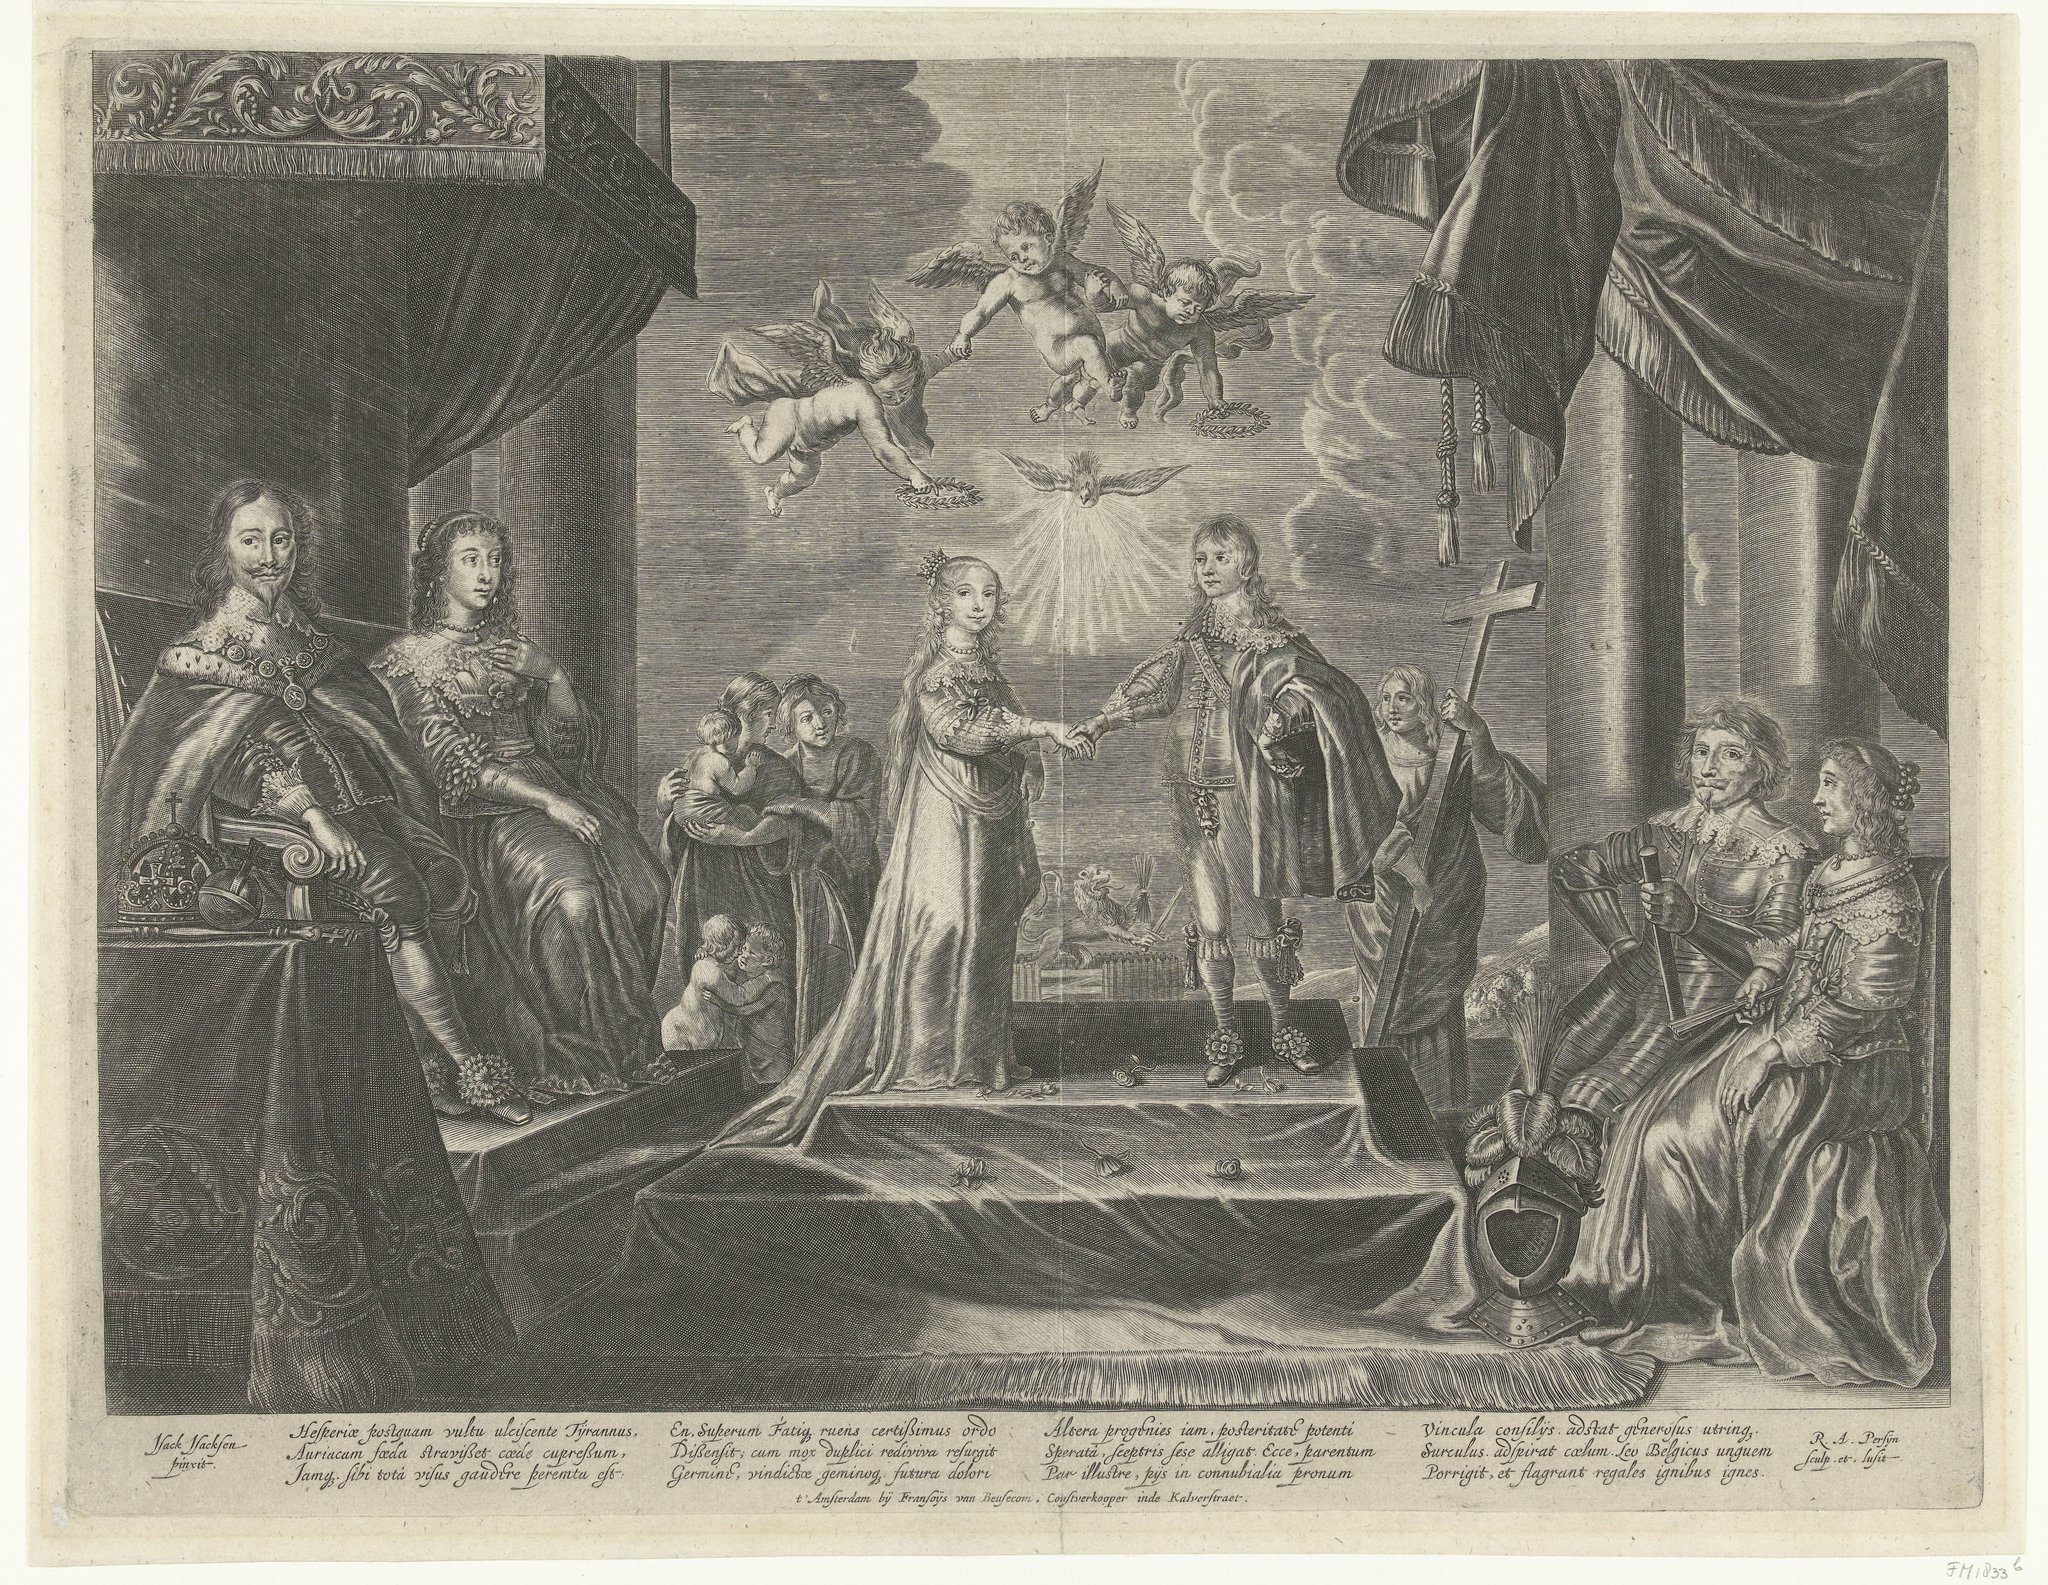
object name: print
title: Huwelijk van prins Willem II en Maria Stuart, 1641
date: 1641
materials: paper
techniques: engraving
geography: amsterdam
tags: henriëtta maria van frankrijk (koningin van engeland, schotland en ierland), delft, the hague, frederick henry (prince of orange), william ii (prince of orange), amalia of solms-braunfels, mary henrietta stuart, london, karel i (koning van engeland), marriage, married couple, 'matrimonium'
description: Het huwelijk van prins Willem II en prinses Maria Stuart, 2 mei 1641. Links de ouders van de bruid: de Engelse koning Karel I en zijn vrouw Henrietta Maria. Rechts de ouders van de bruidegom: Frederik Hendrik en Amalia van Solms. Op de achtergrond allegorische figuren van Liefde en Hoop en Rechtvaardigheid en de Hollandse Leeuw in de Hollandse Tuin. Boven het paar de duif van de Heilige Geest en putti met lauwerkransen. Onder de voorstelling 4 verzen van 4 regels in het Latijn.